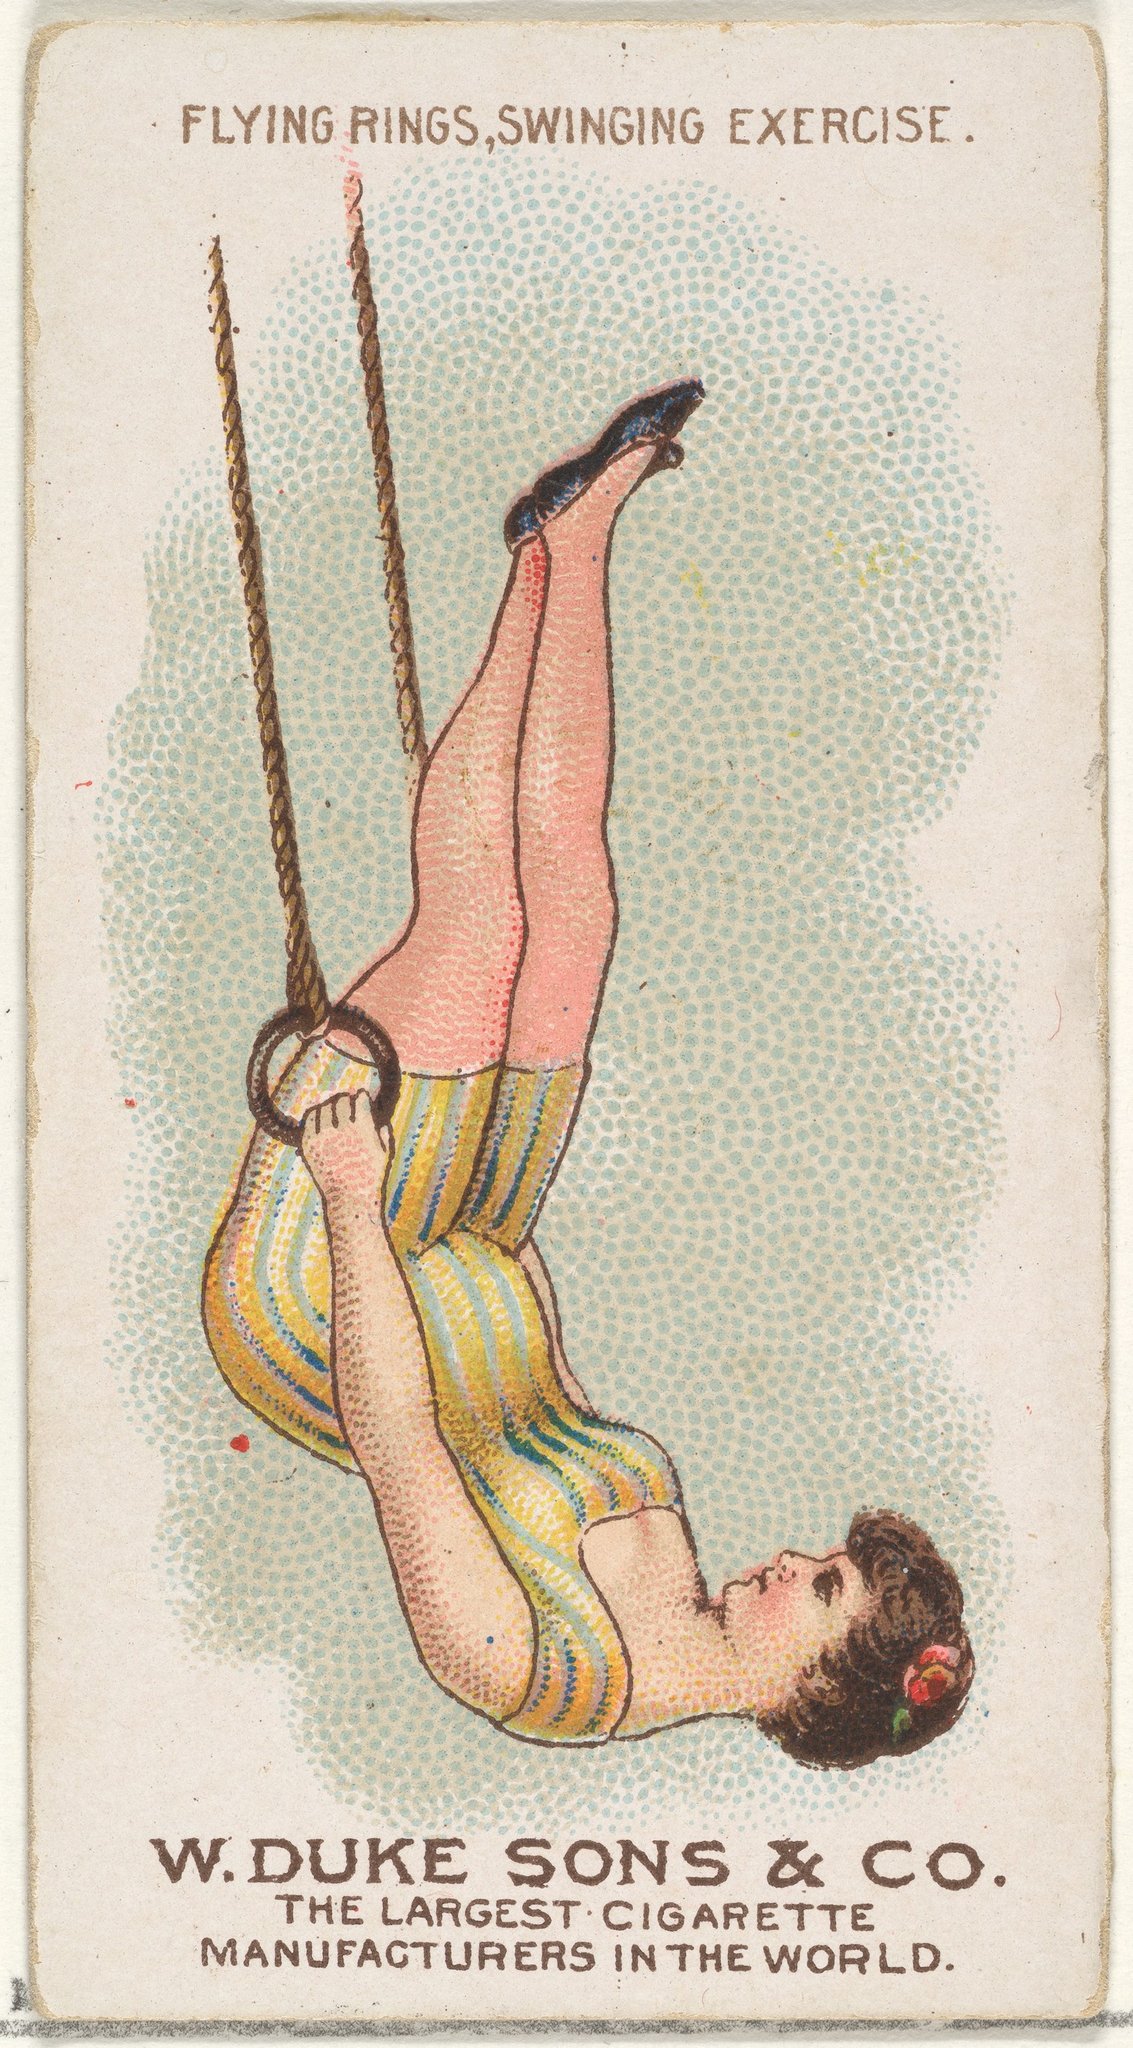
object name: print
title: Flying Rings Swinging Exercise, from the Gymnastic Exercises series (N77) for Duke brand cigarettes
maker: w. duke, sons & co.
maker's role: publisher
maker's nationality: american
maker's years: 1870-1920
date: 1887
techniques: color lithograph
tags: women,athletes